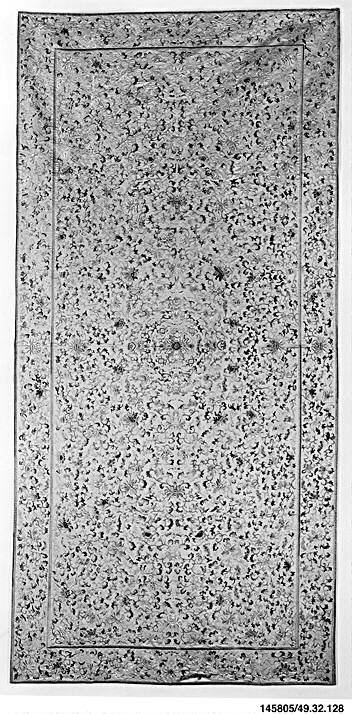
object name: furniture cover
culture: chinese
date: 1701-1800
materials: silk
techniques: embroidery